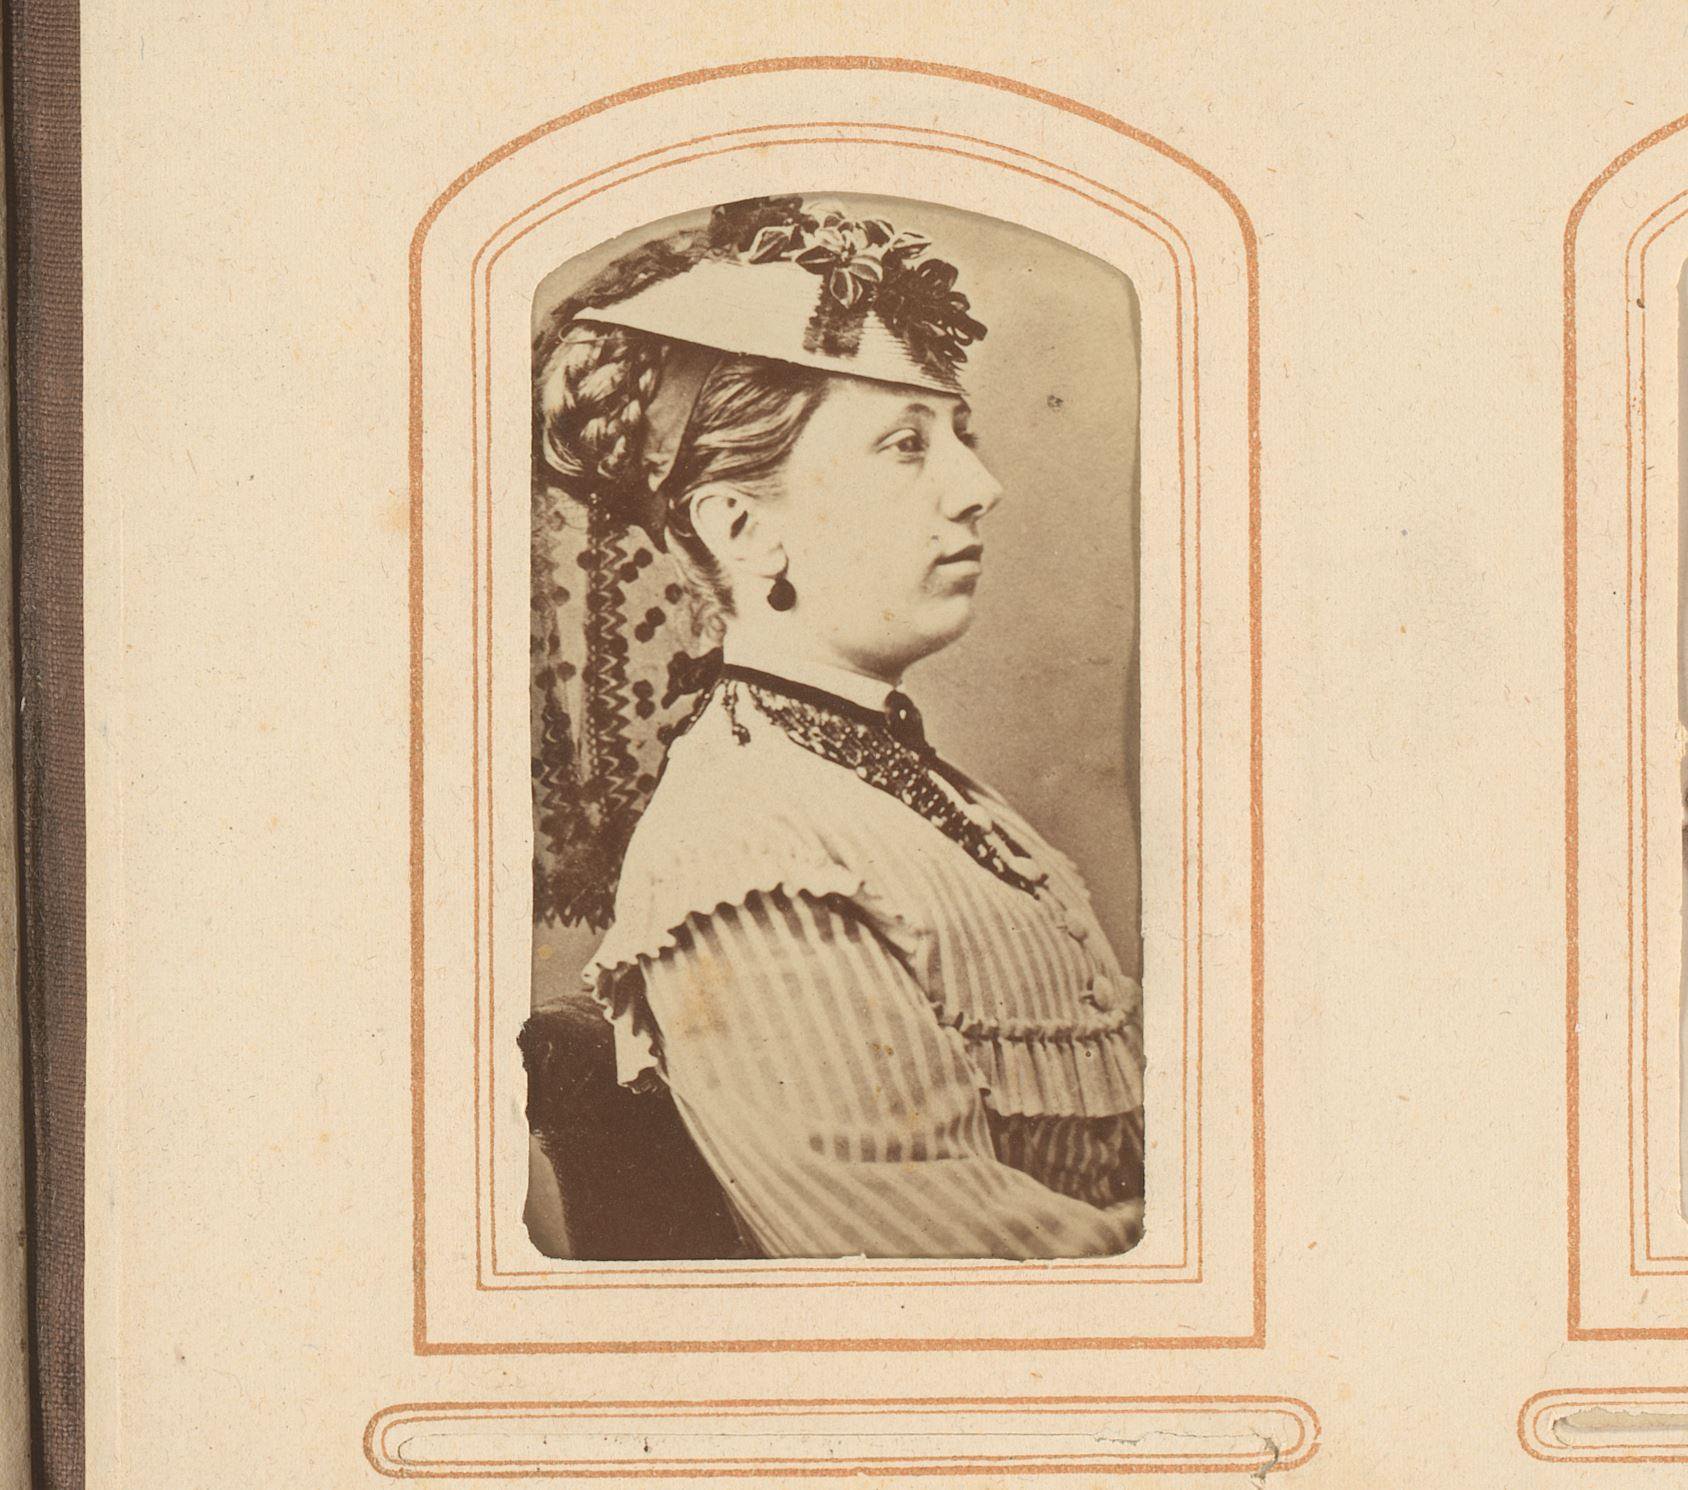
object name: photograph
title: Porteret van Therese Bobey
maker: Anonymous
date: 1855-1890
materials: cardboard, photographic support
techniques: albumen print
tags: historical persons, portrait of actor, actress, veil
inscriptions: annotation: ‘Thérese Bobey/ F. [...]’